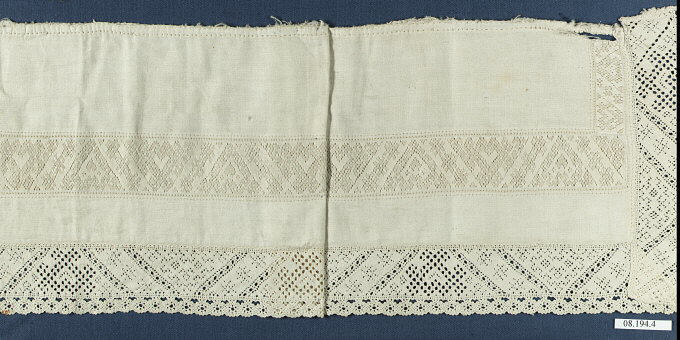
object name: cap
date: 1801-1900